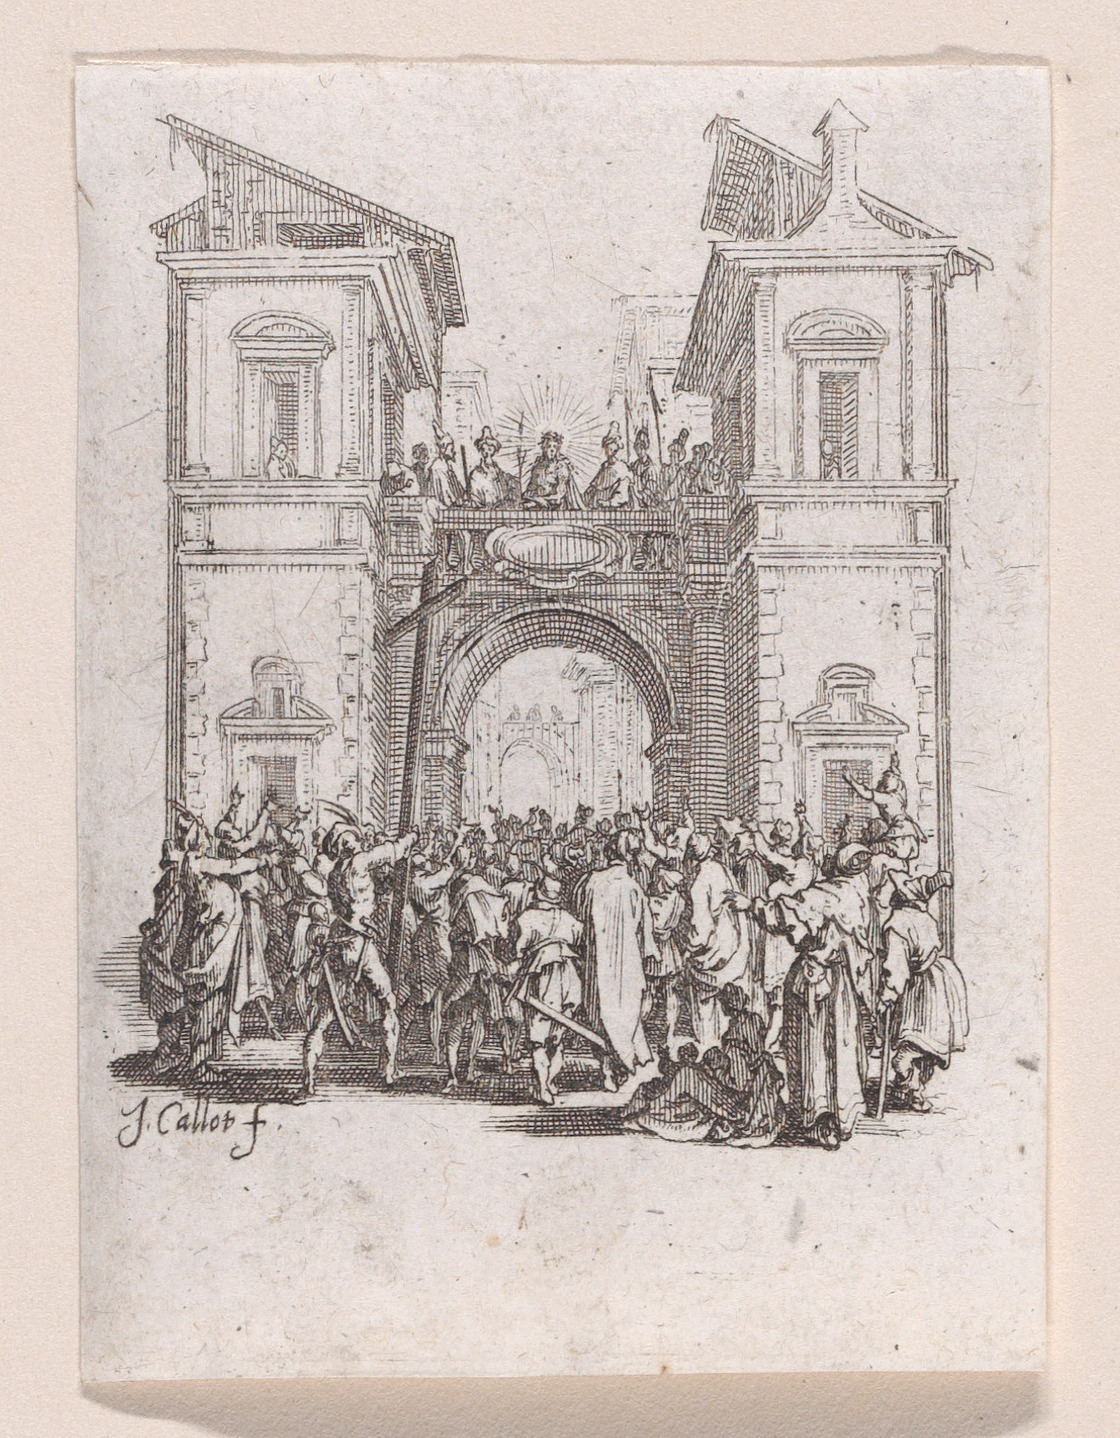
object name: print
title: La Présentation au Peuple (The Presentation to the People), from "La Petite Passion" (The Little Passion)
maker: jacques callot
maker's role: artist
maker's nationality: french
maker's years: 1592-1635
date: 1624-1625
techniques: etching